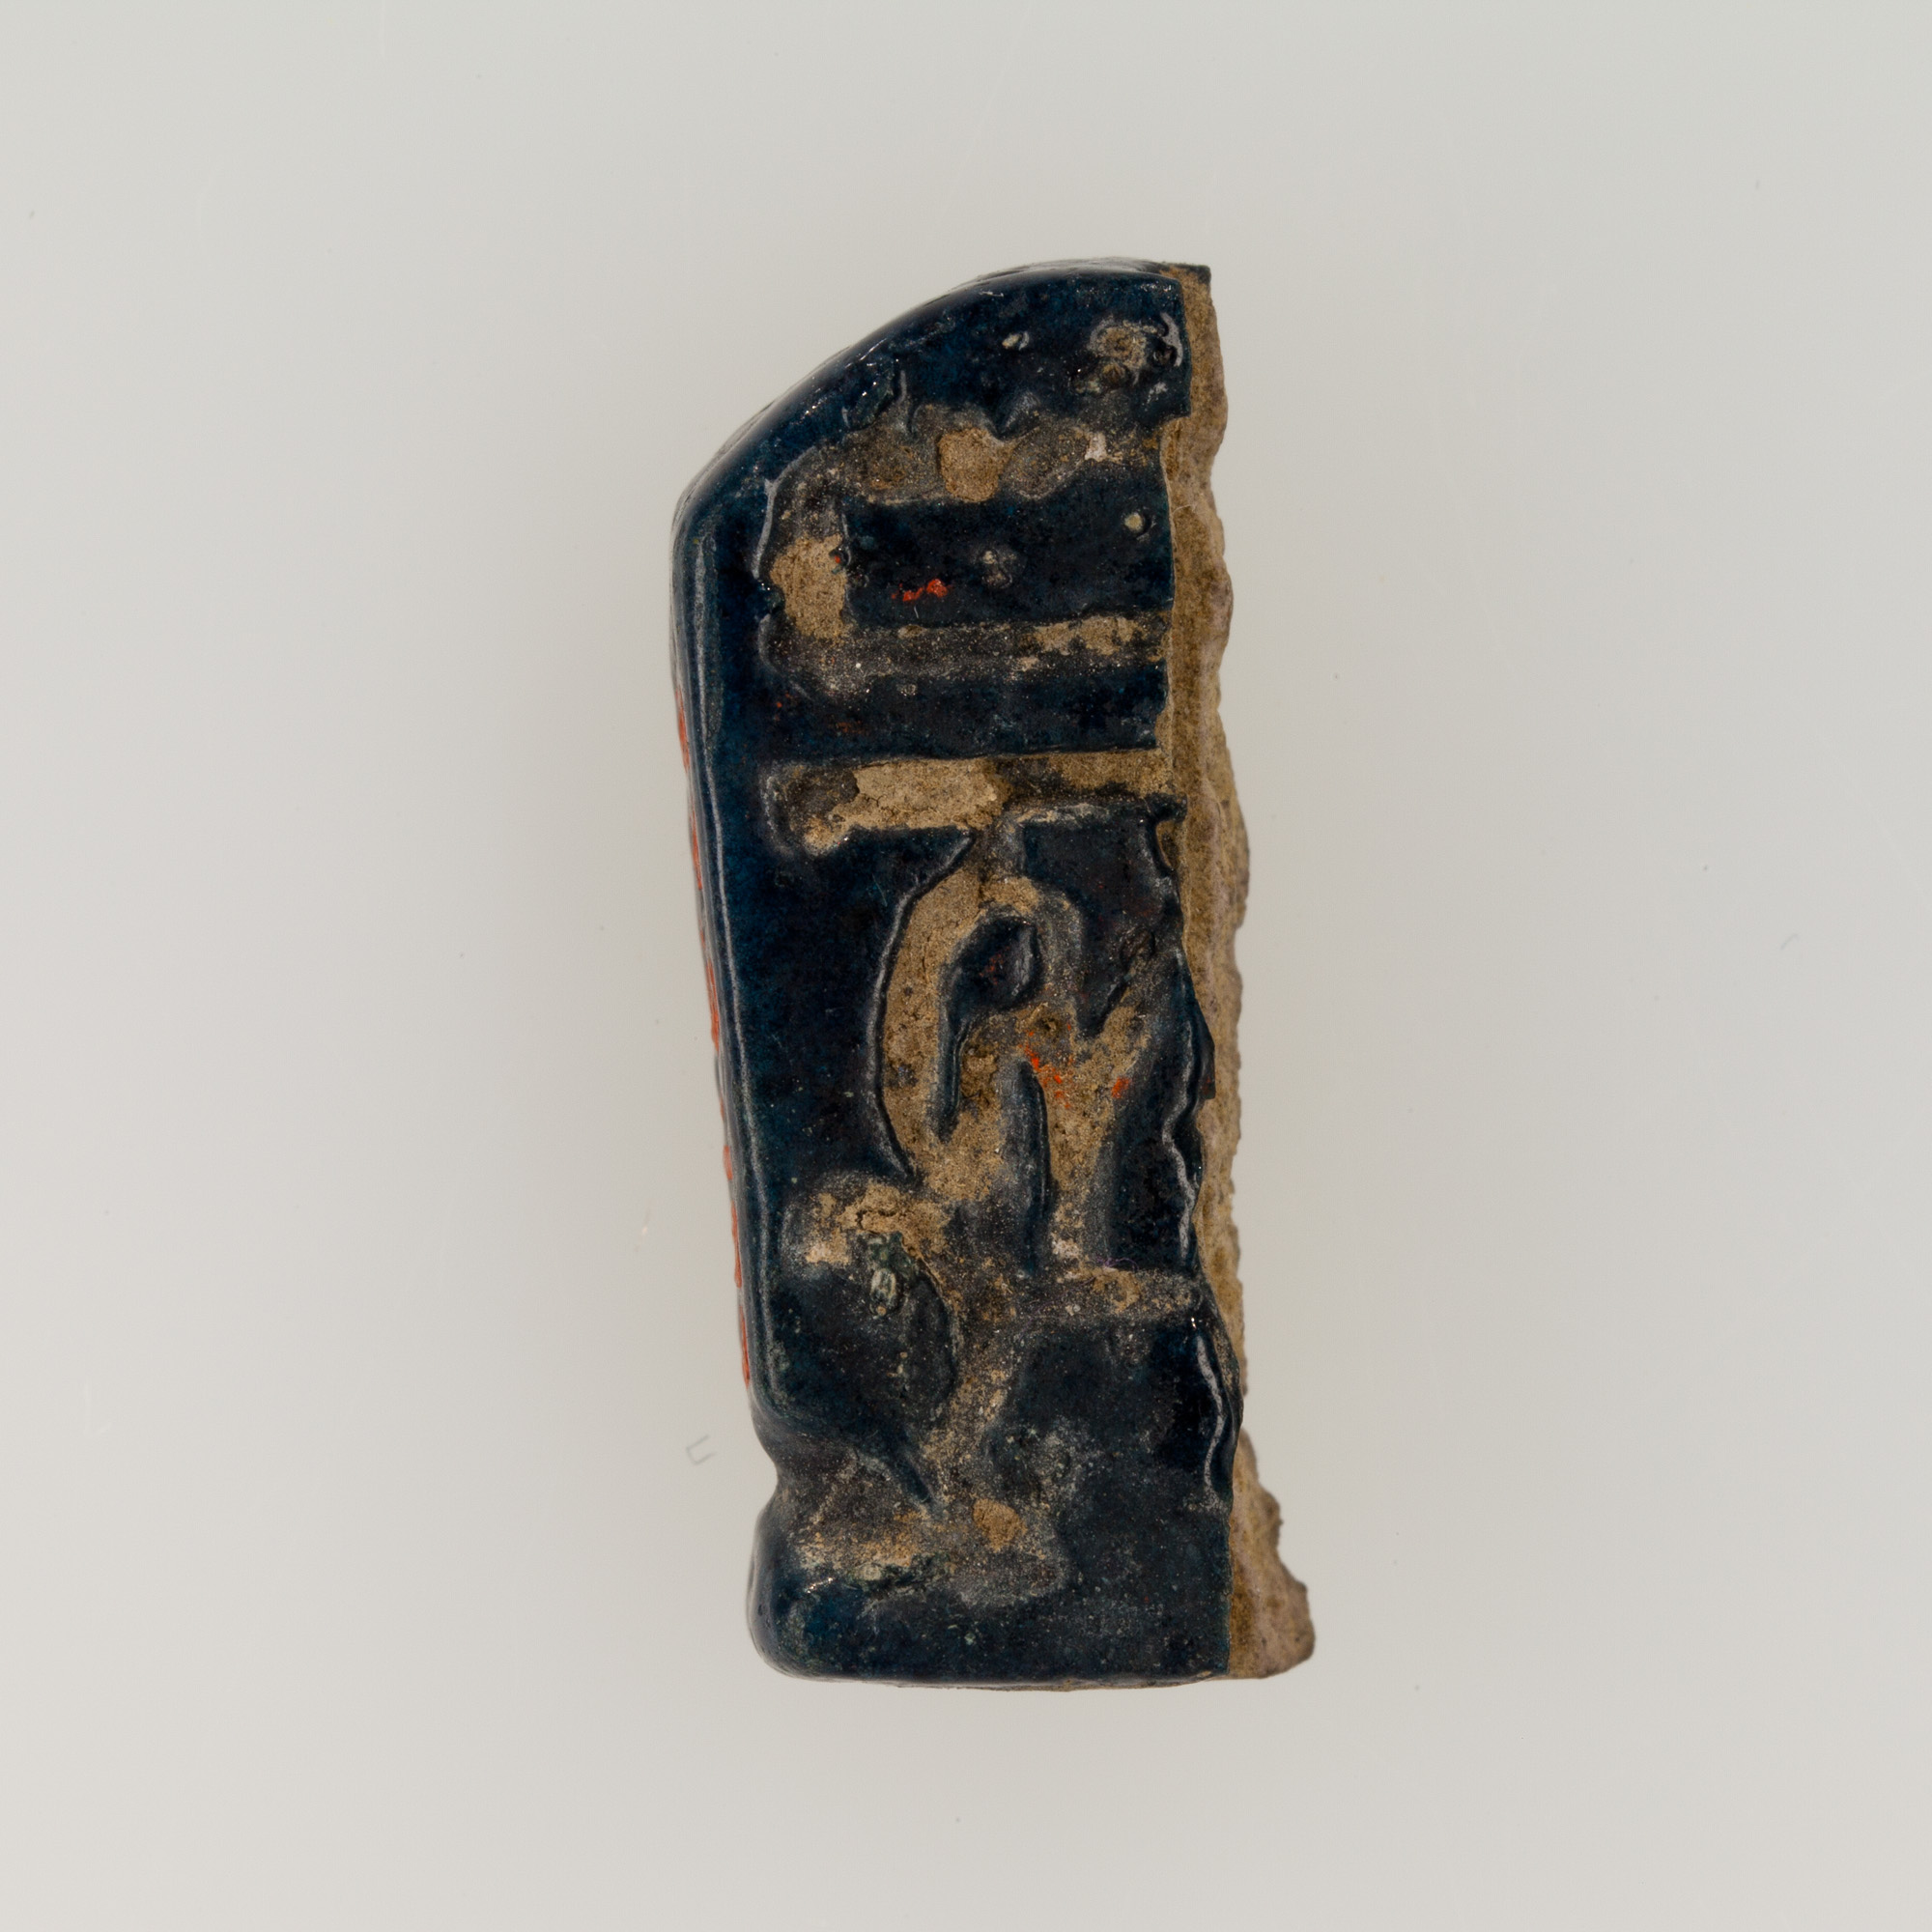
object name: scarab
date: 1479-1458 BCE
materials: faience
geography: egypt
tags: scarabs